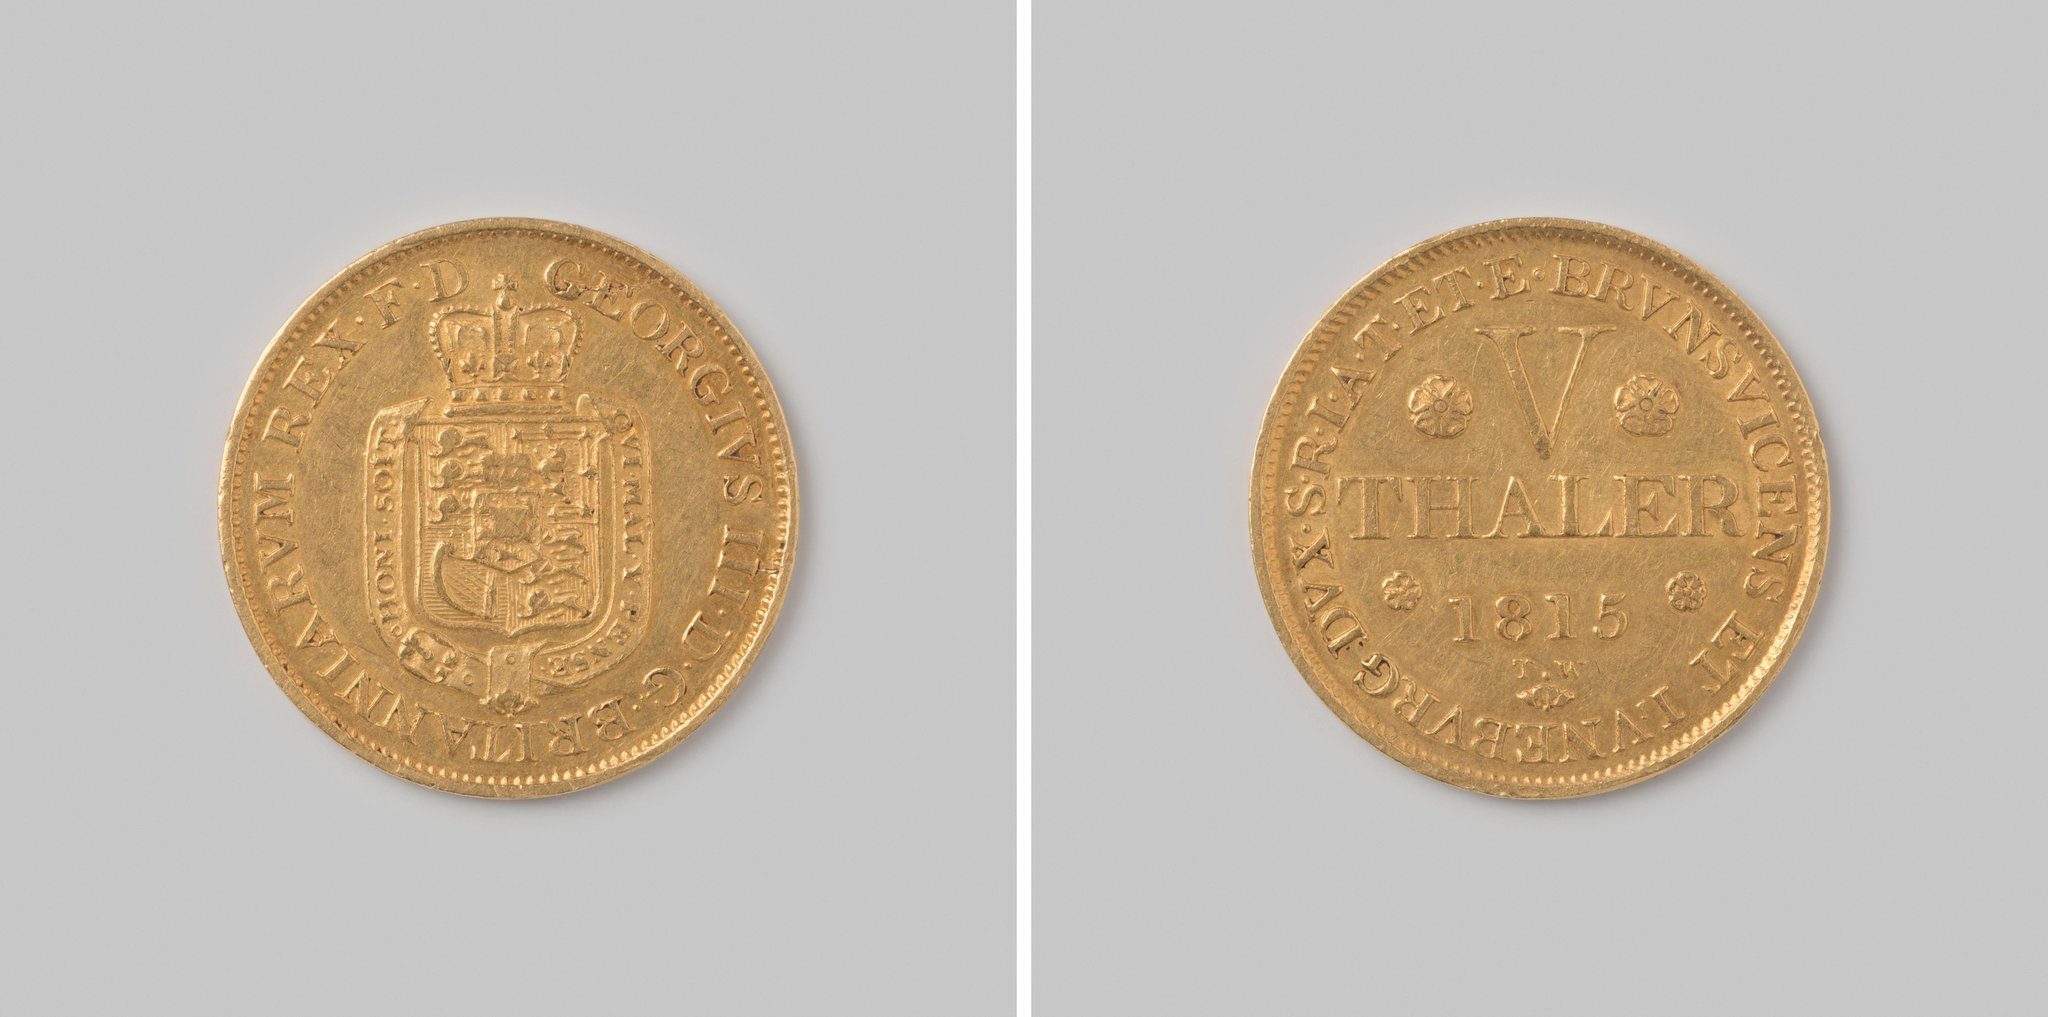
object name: coin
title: Vijf taler uit het koninkrijk Hannover van Georg III, 1815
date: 1815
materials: gold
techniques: striking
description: Gouden munt. Voorzijde: met band van de orde van de kousenband omhangen gekroond wapenschild. Keerzijde: waarde-aanduiding in twee regels, waaronder jaartal. Kartelrand.